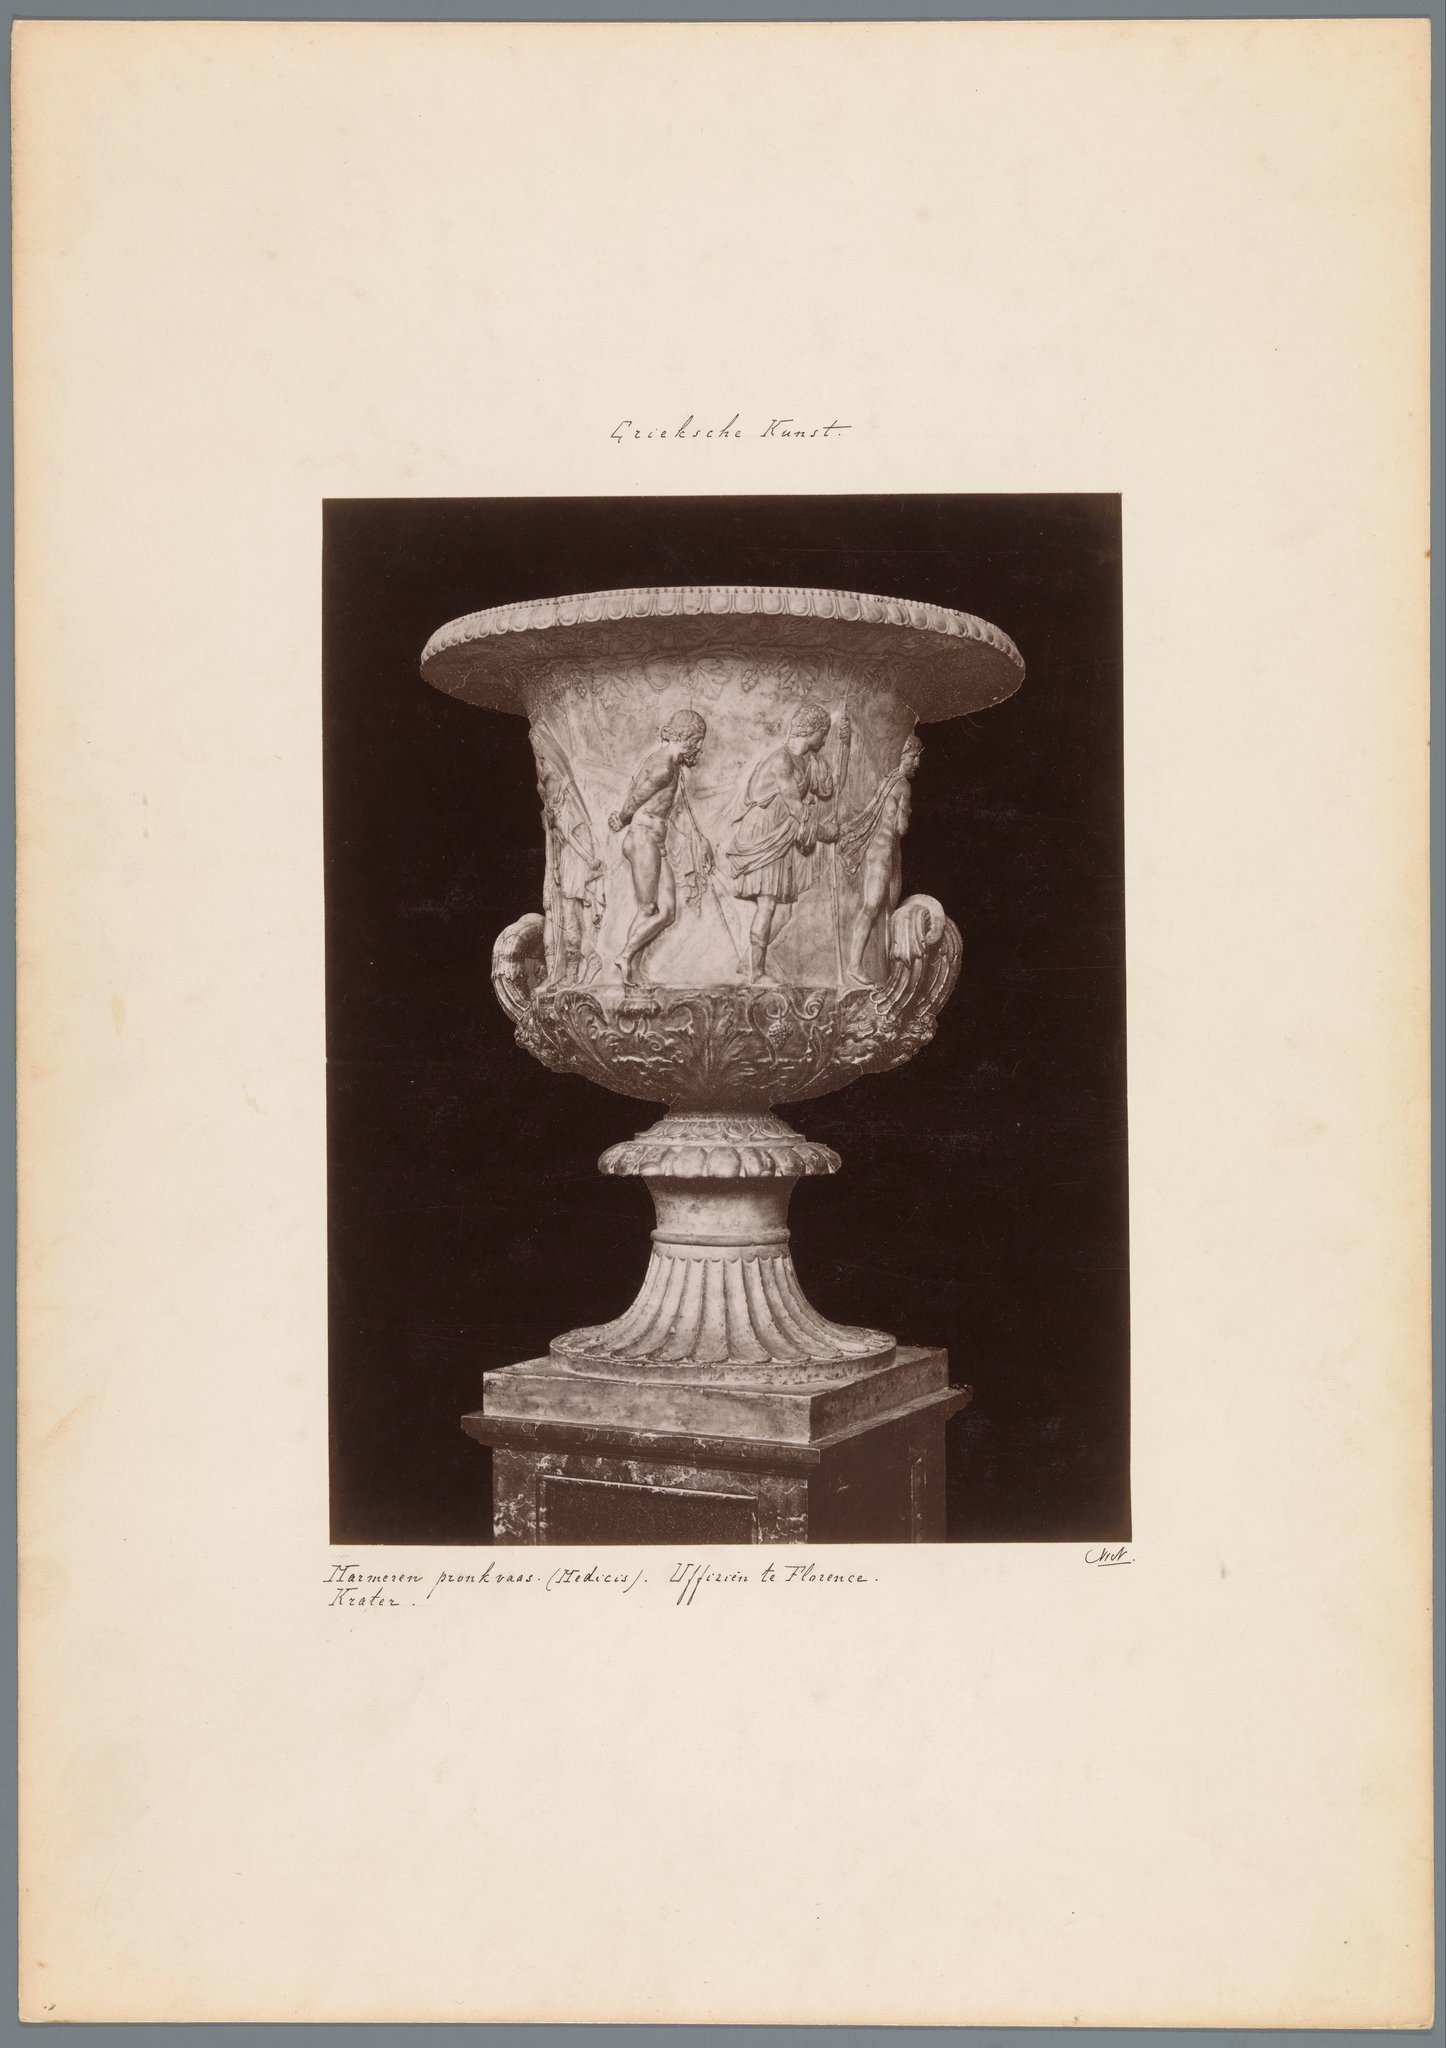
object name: photograph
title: Marmeren vaas met reliëf in de Galleria degli Uffizi te Florence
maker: Anonymous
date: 1875-1900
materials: cardboard, photographic support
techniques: albumen print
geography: galleria degli uffizi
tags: container of ceramics: jar, jug, pot, vase, sculpture (+ relief ~ sculpture)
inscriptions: collector's mark: ‘INSTITUUT VOOR KUNST- NIJVERHEIDSONDERWIJS GABRIËL METSUSTRAAT No. 16. AMSTERDAM’, collector's mark: ‘KUNSTNIJVERHEIDSCHOOL QUELLINUS AMSTERDAM FRANS HALSSTRAAT 14.’, inscription: ‘Grieksche Kunst. Marmeren pronkvaas (...) Krater .’, inscription: ‘CWN.’